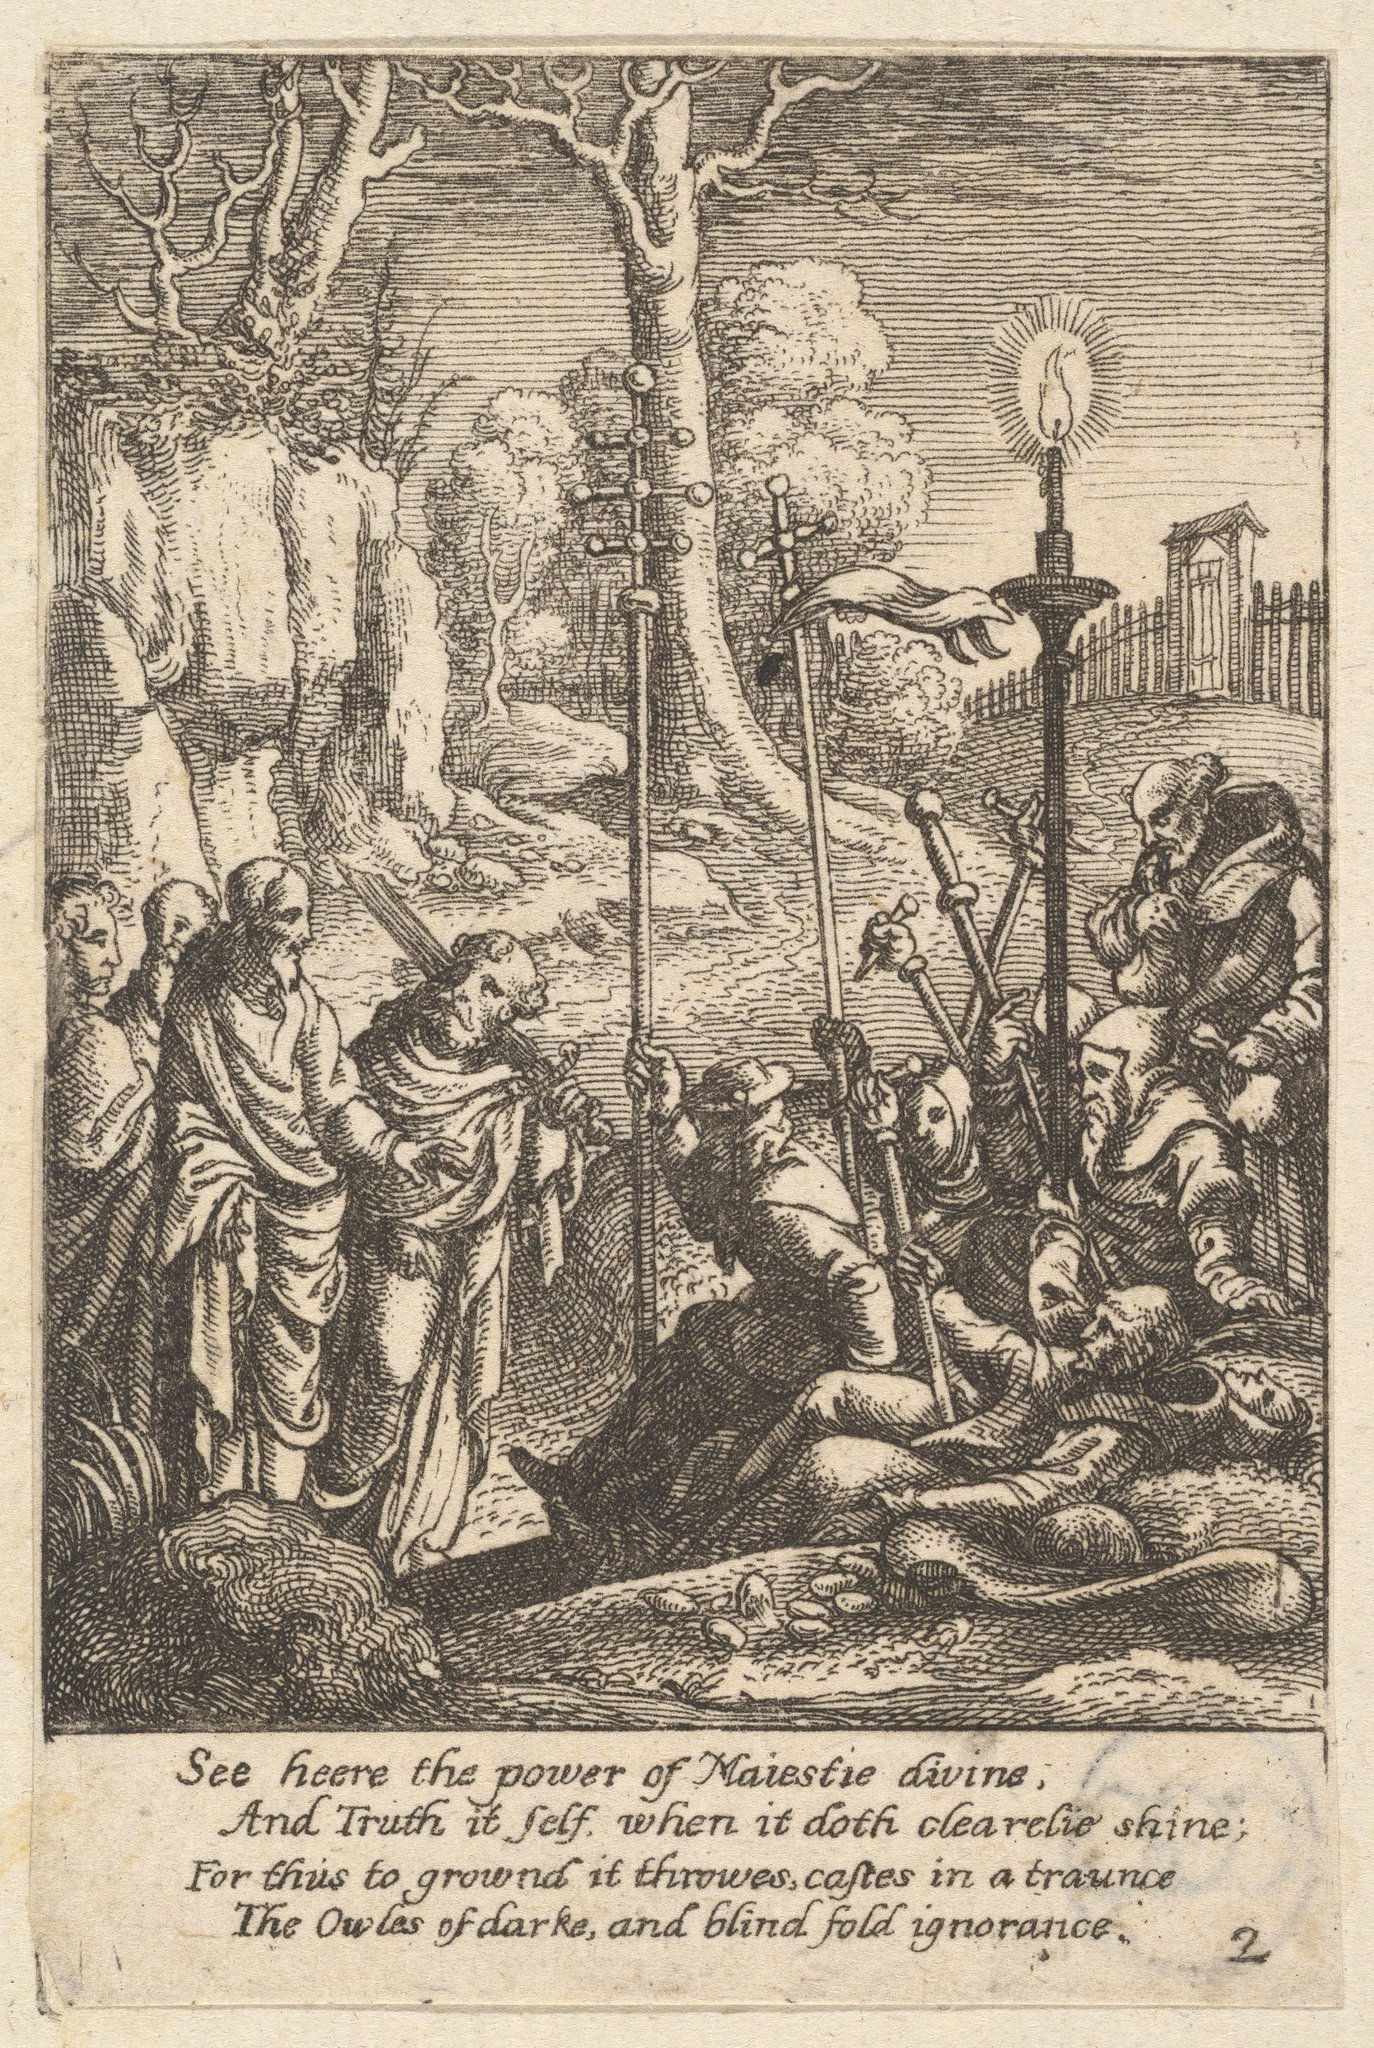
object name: print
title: Jesus confronting his detractors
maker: wenceslaus hollar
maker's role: artist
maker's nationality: bohemian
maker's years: 1607-1677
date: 1644-1652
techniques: etching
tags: men,trees,saint peter,jesus